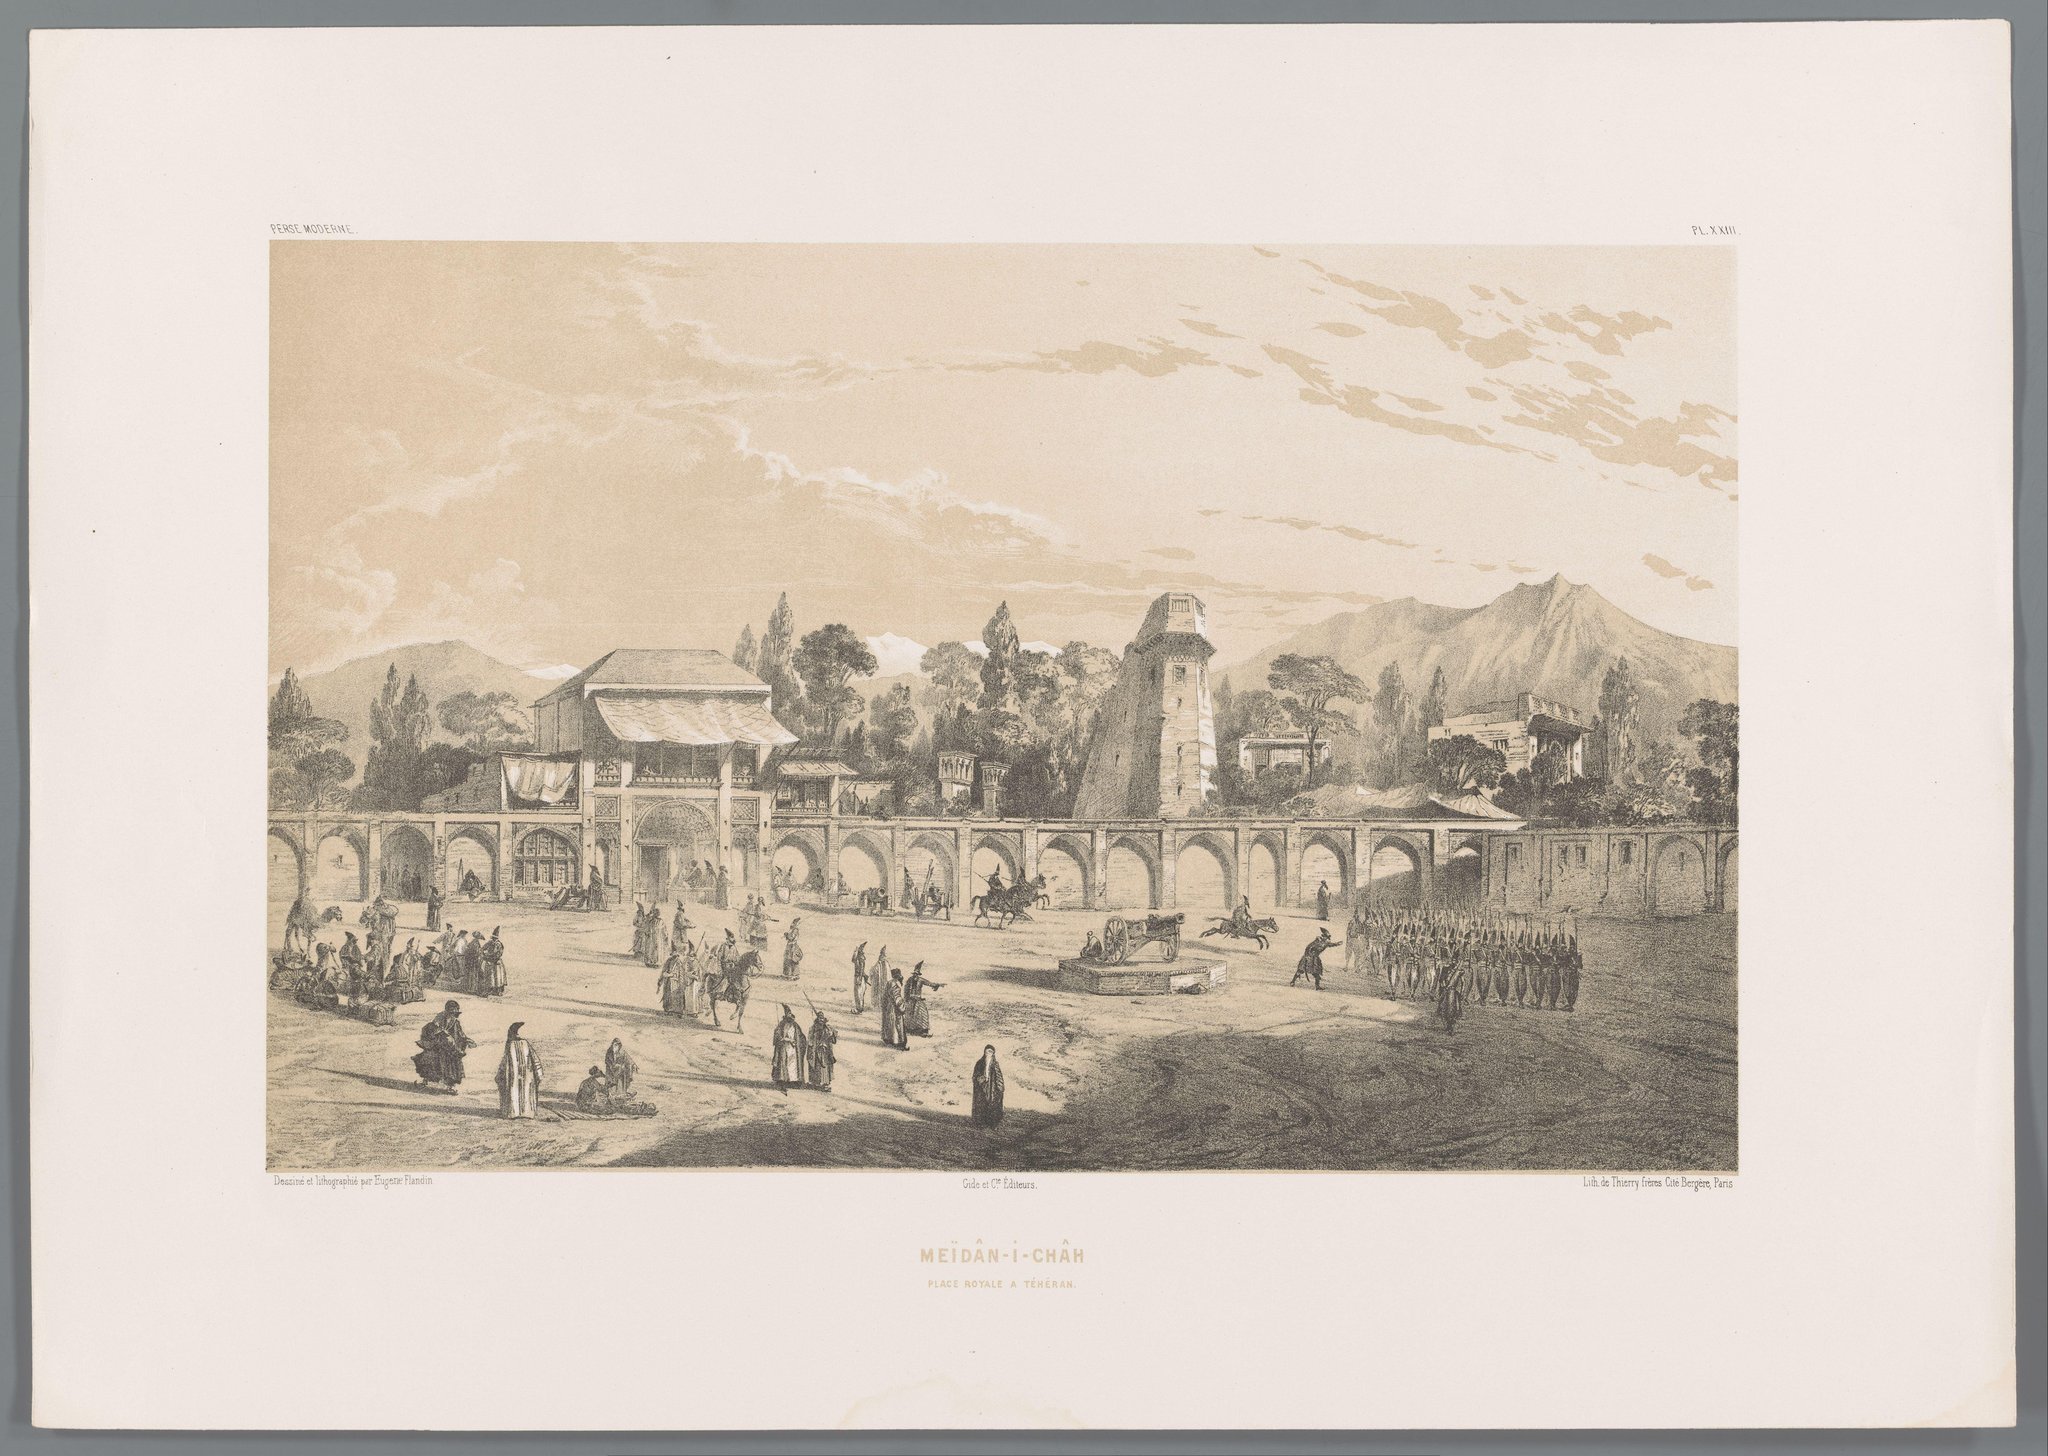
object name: print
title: Meidan i Shah, het koninklijk plein in Teheran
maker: eugène flandin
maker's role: painter, print maker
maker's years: 1809-1889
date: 1843-1854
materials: paper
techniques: tone lithography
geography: paris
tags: square, place, circus, etc., drill ~ military training, firearms: cannon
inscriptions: collector's mark: Lugt 2228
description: Prent uit: Coste, Pascal-Xavier en Eugène Napoléon Flandin. Voyage en Perse de mm. Eugène Flandin, peintre, et Pascal Coste, architecte (...). 8 dln. Parijs: Gide et Jules Baudry, 1843-1854.